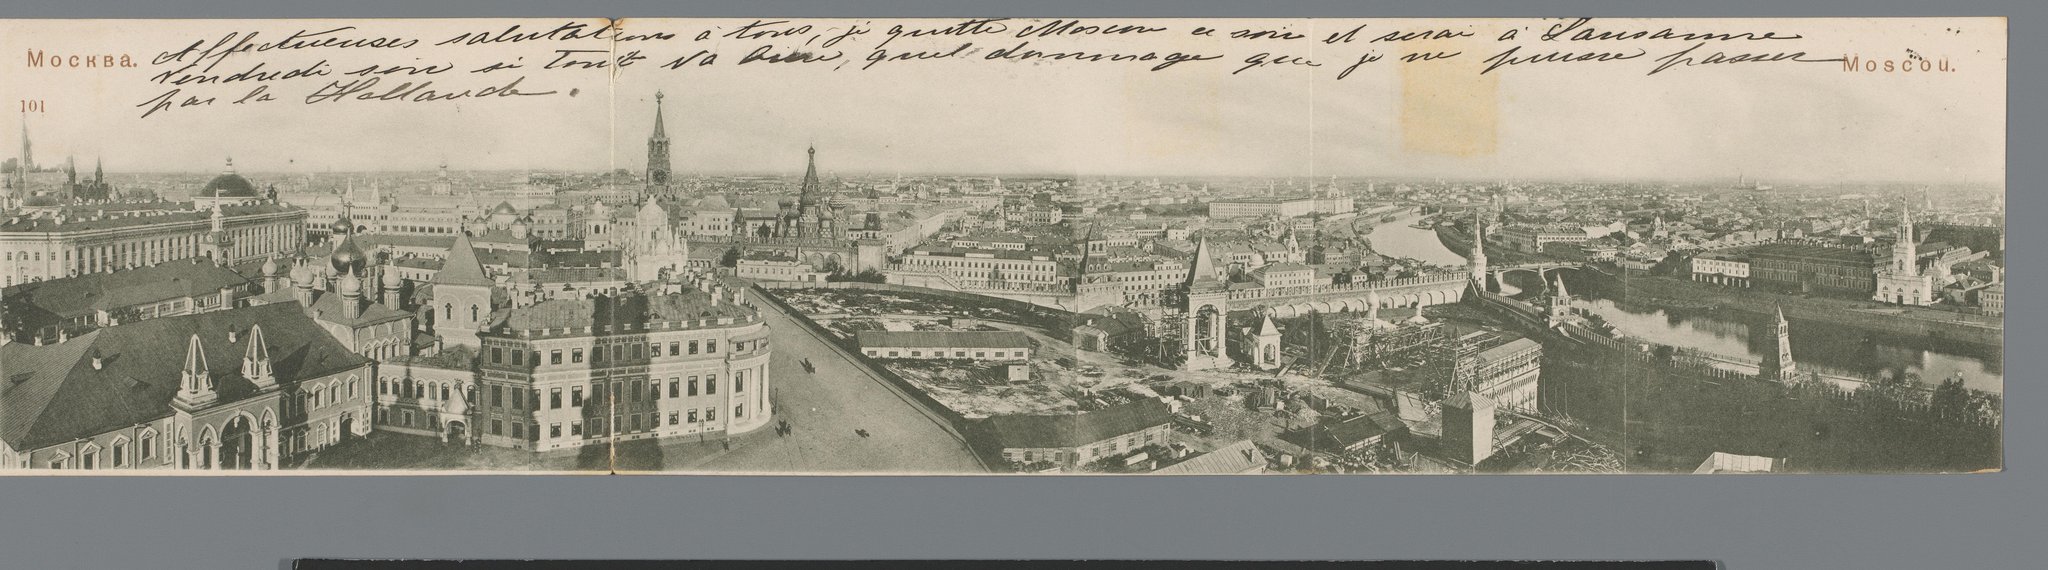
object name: photograph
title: Moskou. Bouwkunst algemeen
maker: Anonymous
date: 1860-1925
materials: photographic support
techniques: photograph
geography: russia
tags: moskou